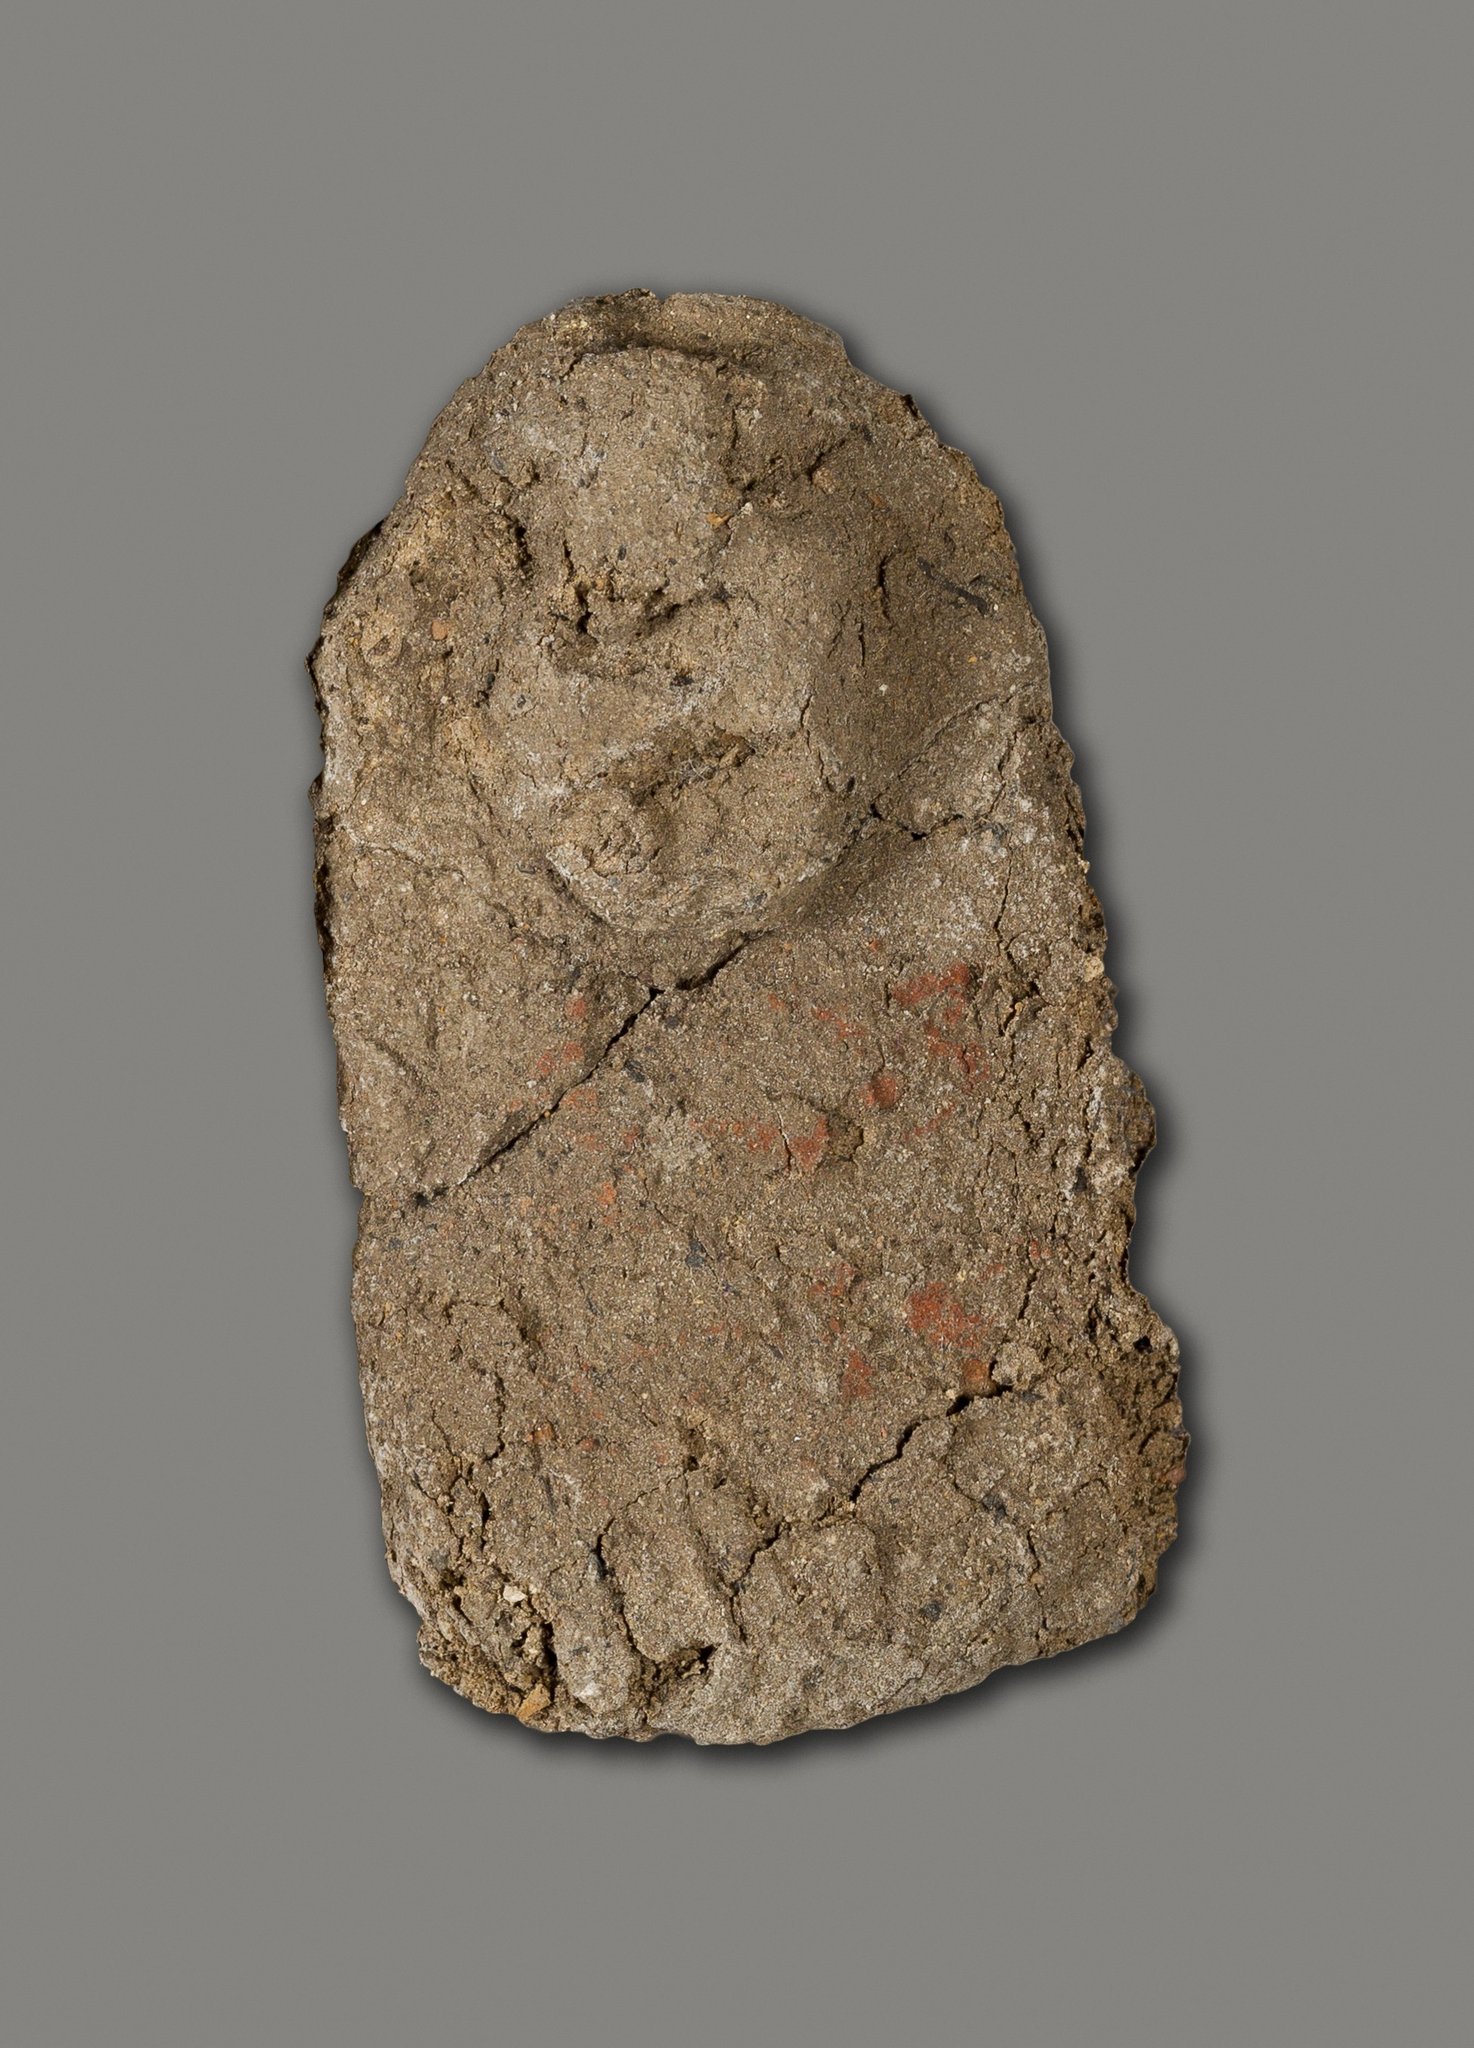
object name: figure, magical, execration, tablet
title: Magical Figure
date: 1802-1550 BCE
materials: clay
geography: egypt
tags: faces